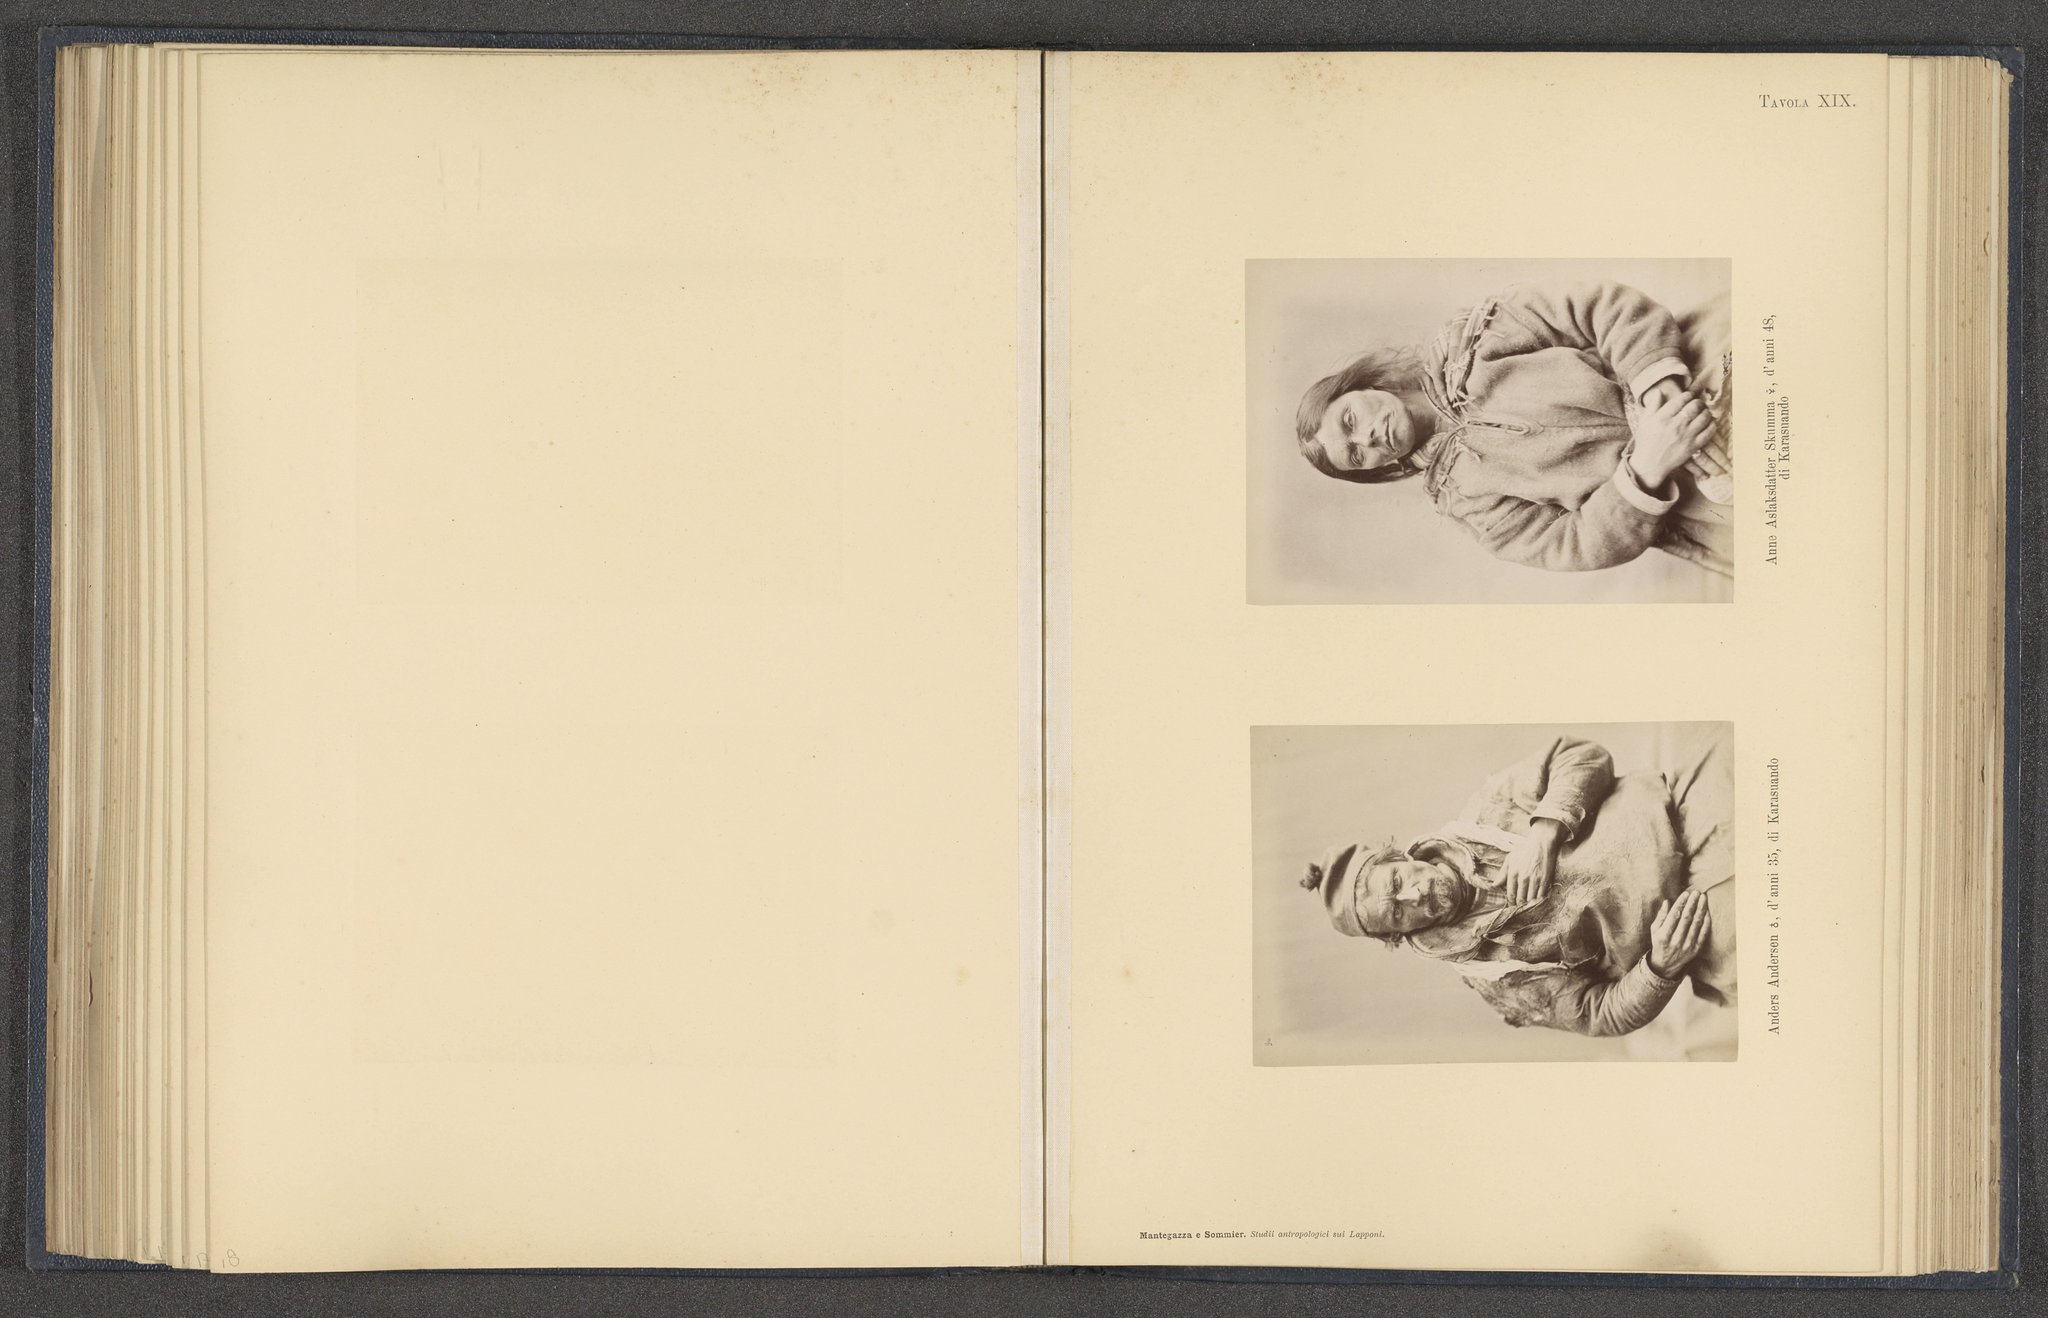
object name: page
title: Twee portretten van Anders Andersen en Anna Aslaksdatter Skumma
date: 1870-1880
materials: paper, photographic support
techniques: albumen print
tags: adult man (+ front view), adult woman (+ front view)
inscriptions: number: ‘Tavola XIX.’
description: Links een vooraanzicht van Anders Andersen, rechts een vooraanzicht van Anna Aslaksdatter Skumma.